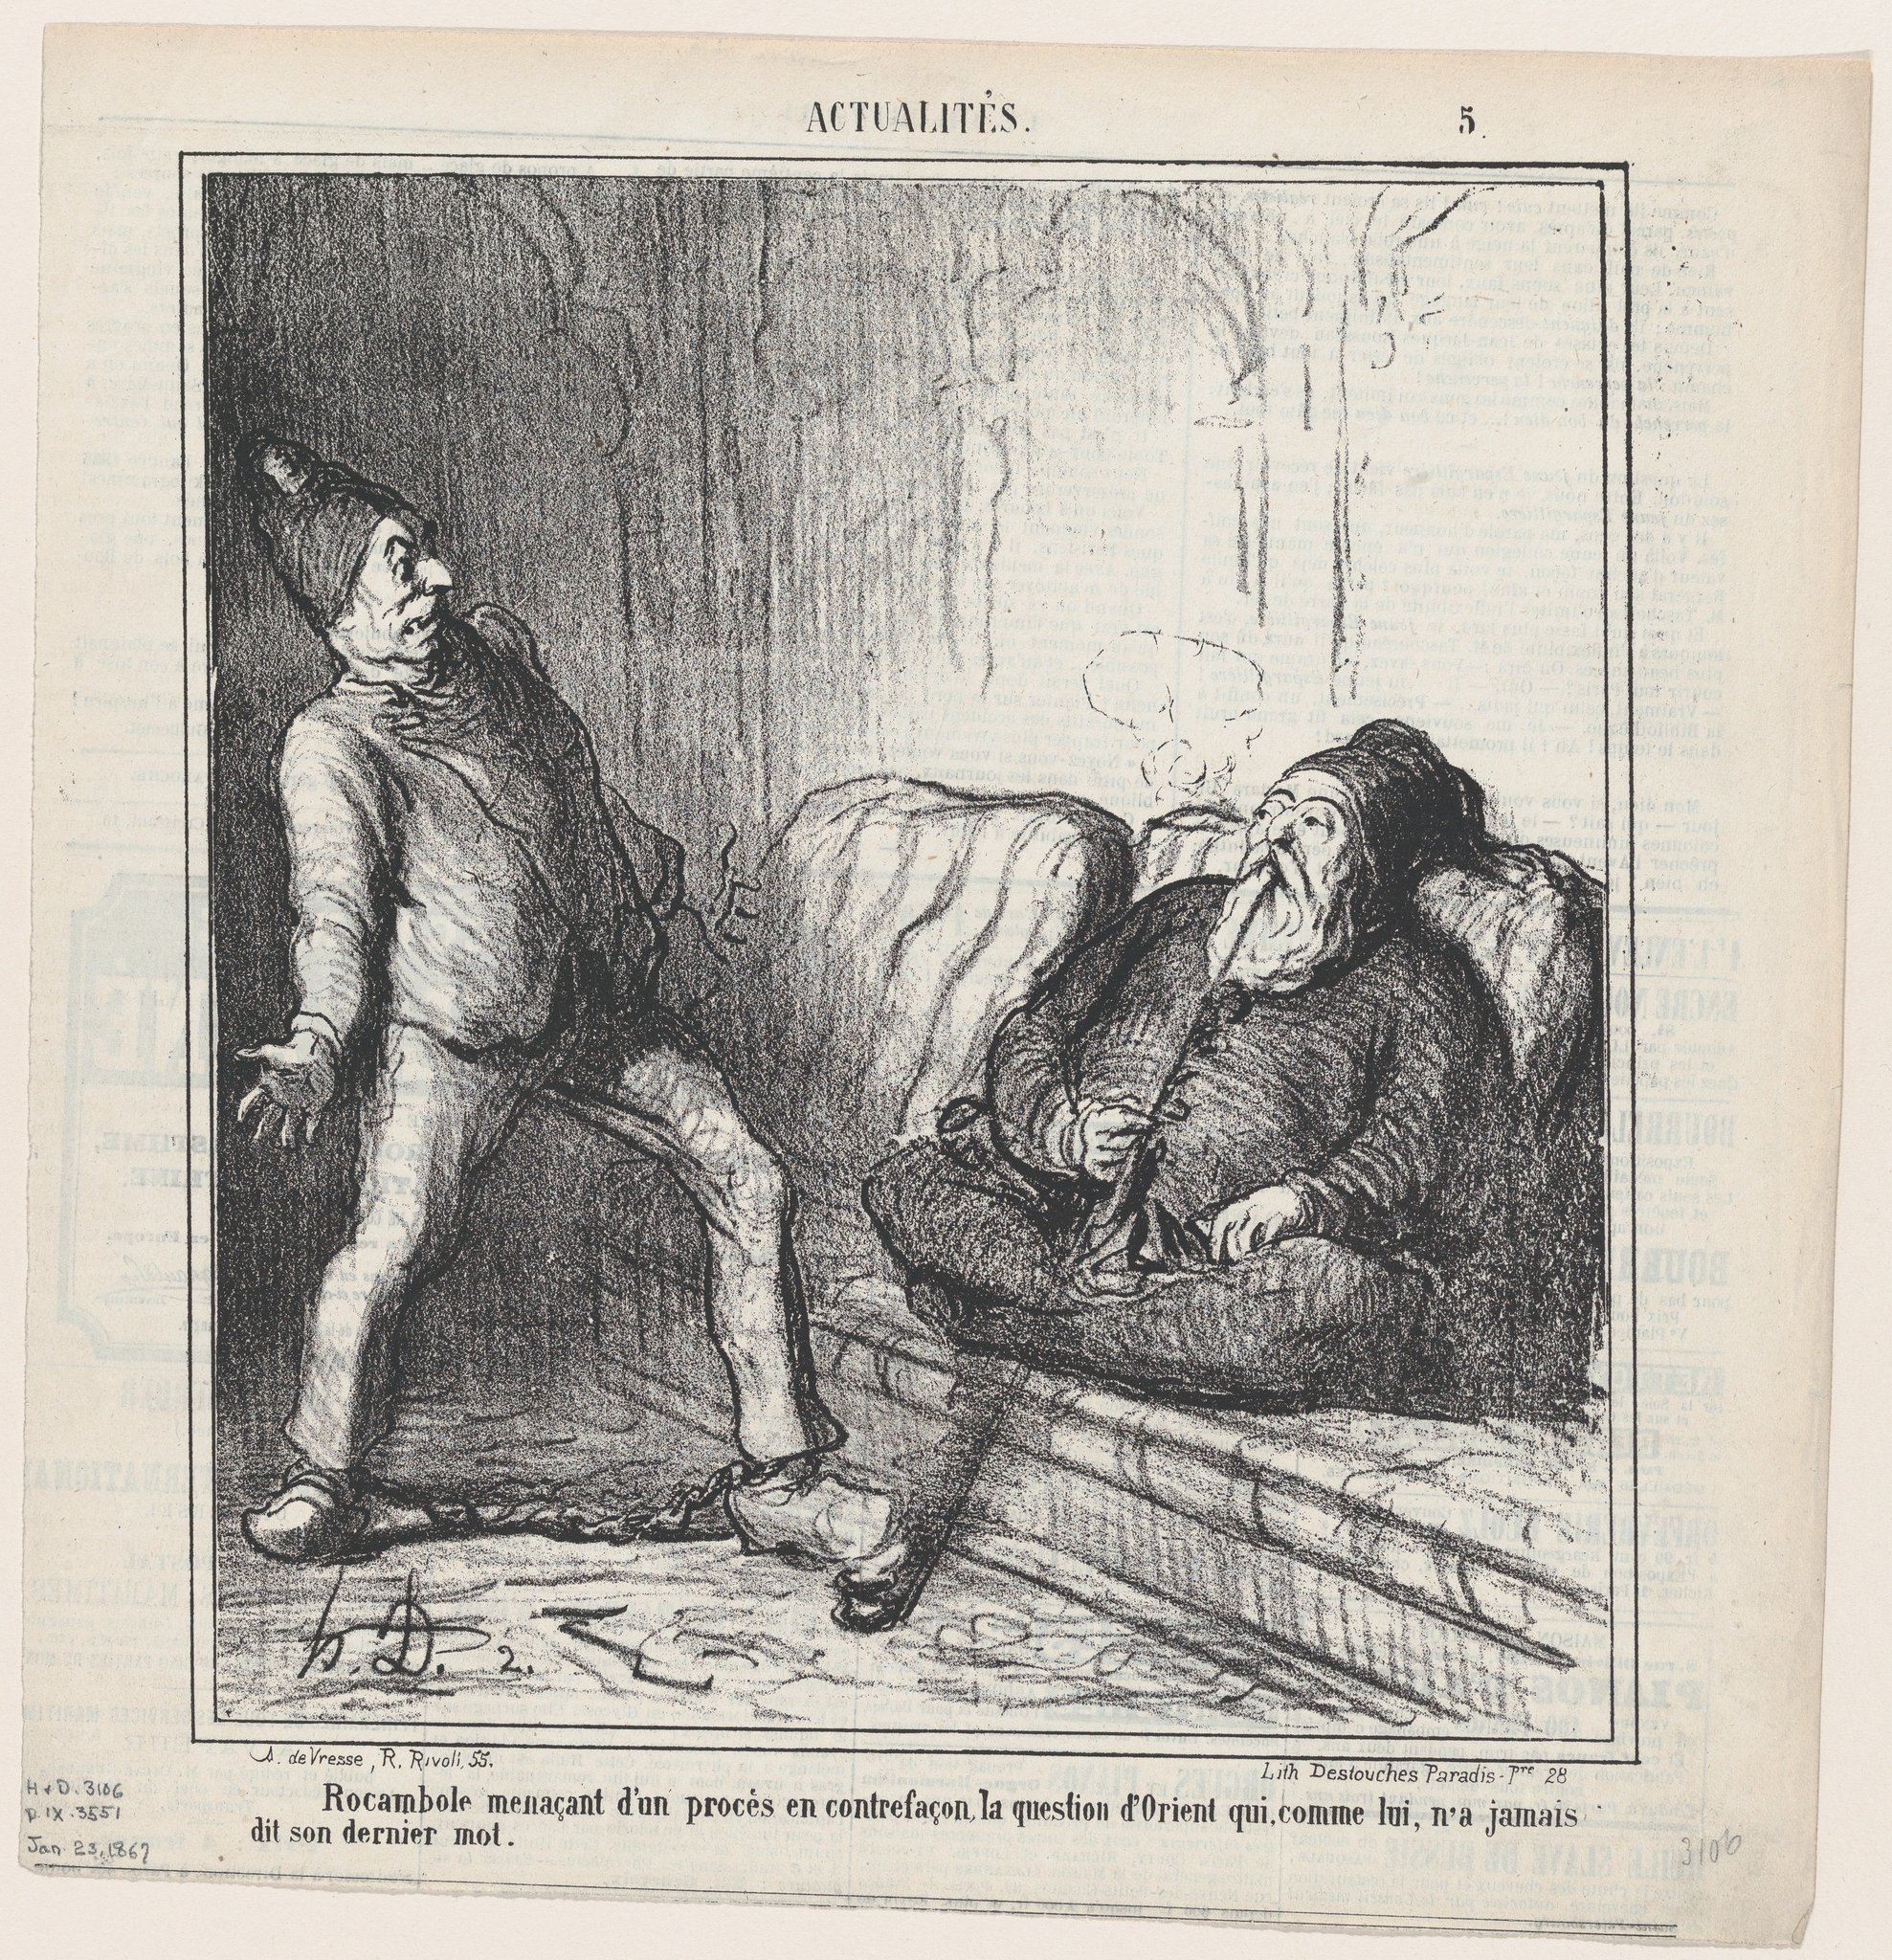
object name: print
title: Rocambole threatening to start a process without end, covering the Oriental question. Since he never finishes anything, chances are that the process also will never be finished, from "News of the Day"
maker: honoré daumier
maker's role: artist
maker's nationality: french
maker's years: 1808-1879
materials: paper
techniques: lithograph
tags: men,smoking